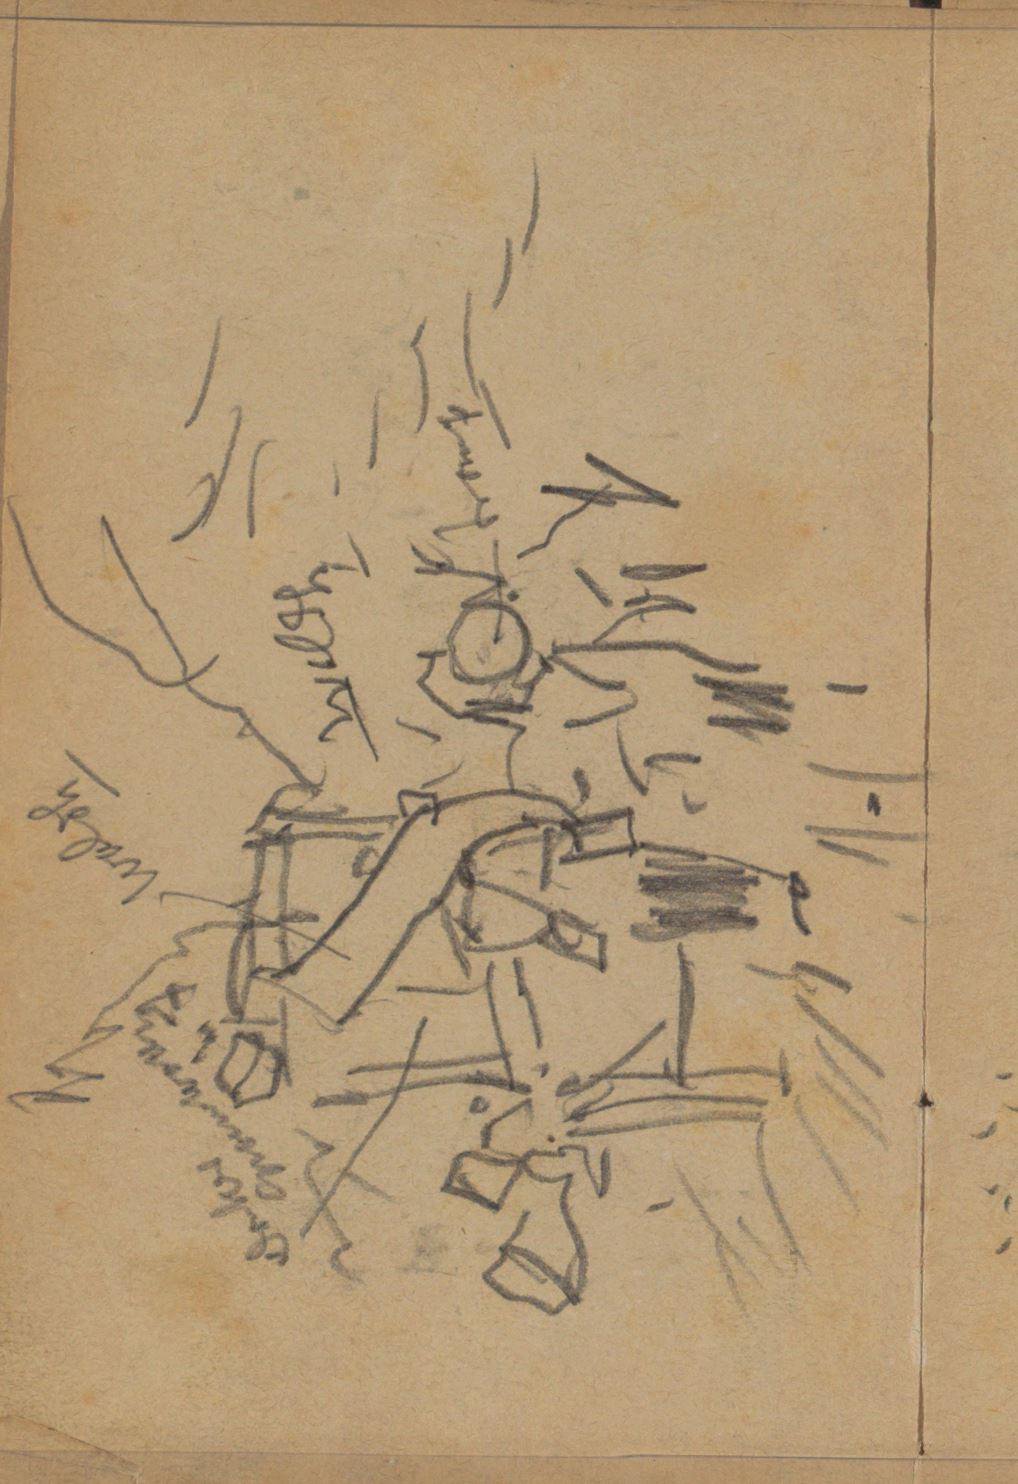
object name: sketchbook leaf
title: Rijtuig in een landschap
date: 1887-1891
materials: paper, pencil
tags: landscapes, four-wheeled, animal-drawn vehicle, e.g.: cab, carriage, coach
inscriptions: kleurnotitie, handgeschreven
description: Pagina 49 uit een schetsboek met 83 bladen.